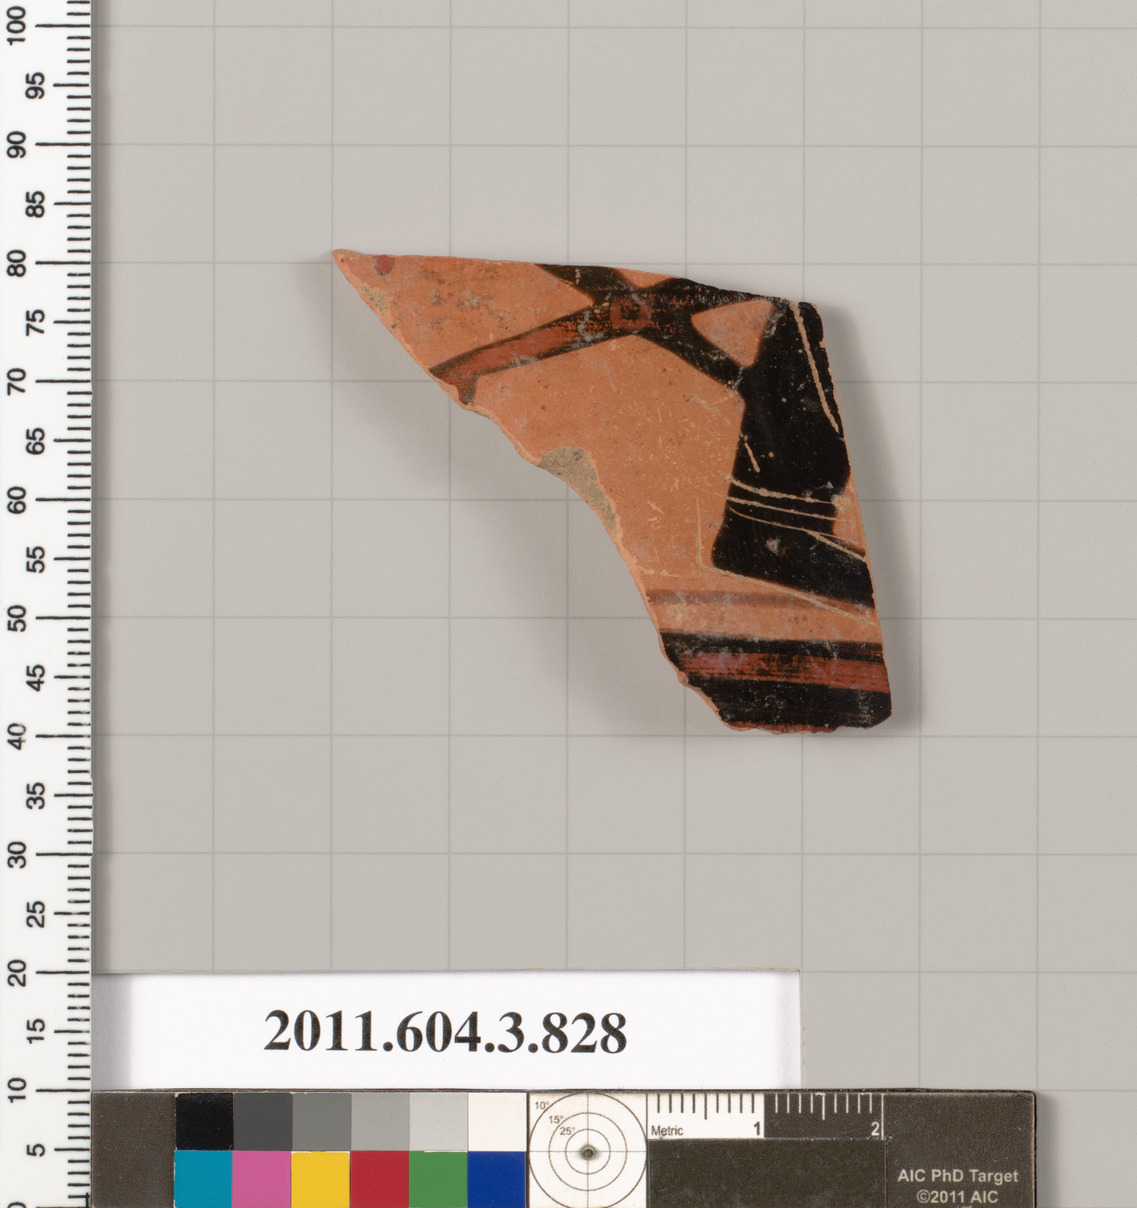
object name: lekythos fragment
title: Terracotta fragment of a lekythos (oil flask)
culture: greek, attic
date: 534-501 BCE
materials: terracotta